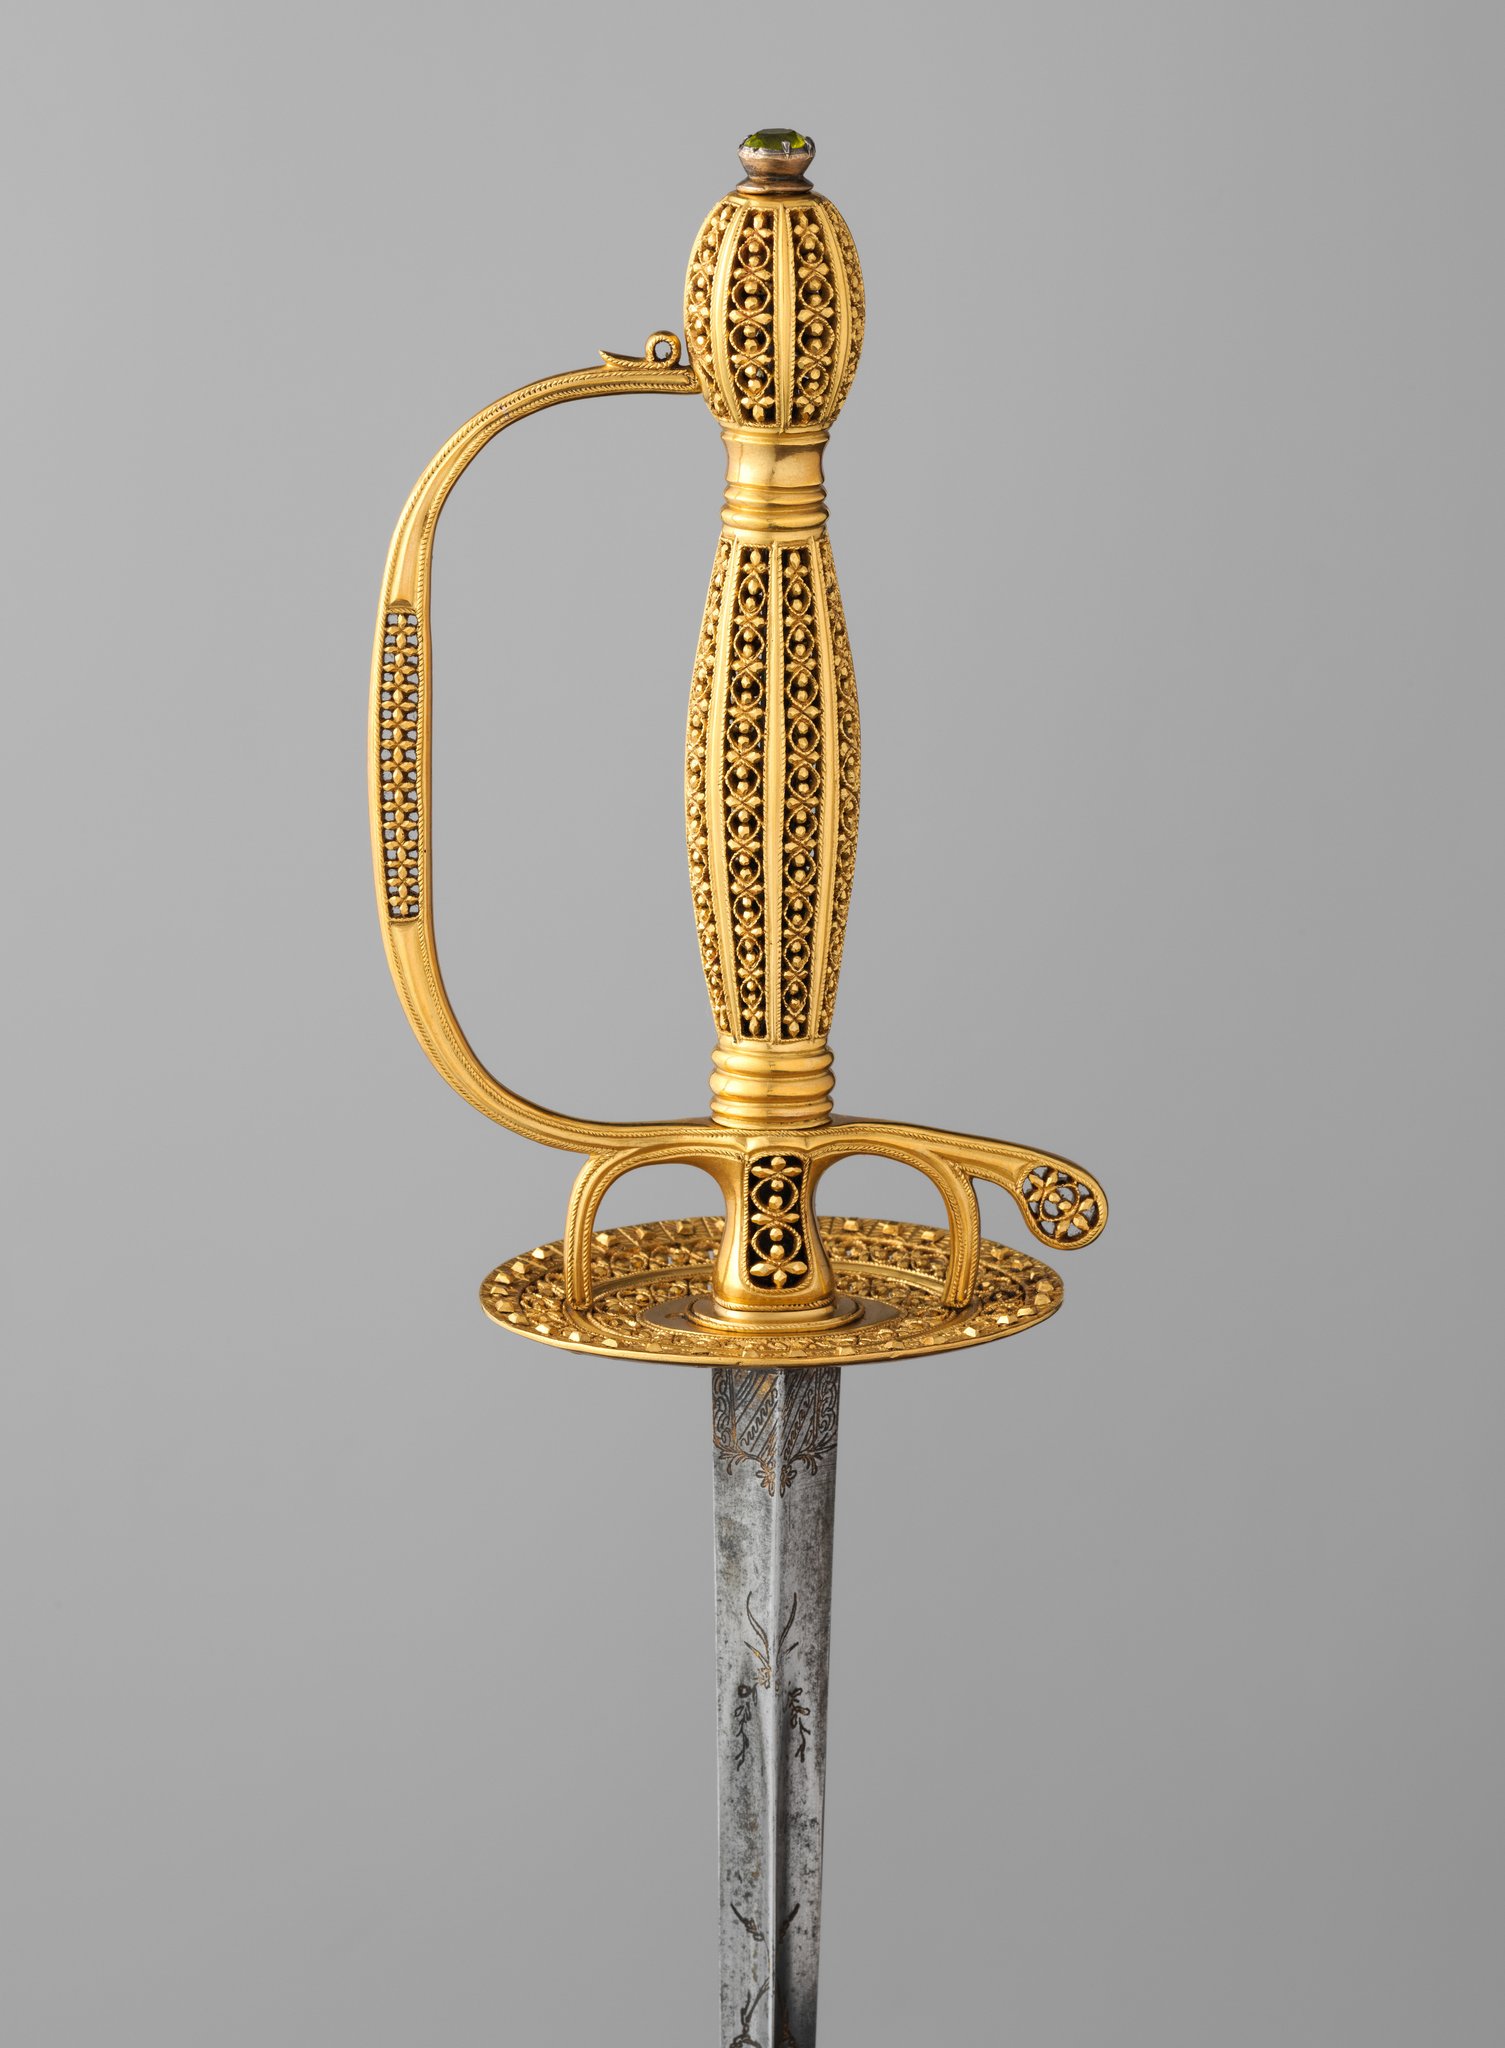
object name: smallsword with scabbard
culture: hilt and scabbard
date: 1790-1800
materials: copper alloy, felt, glass, gold, steel, parchment, wood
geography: germany